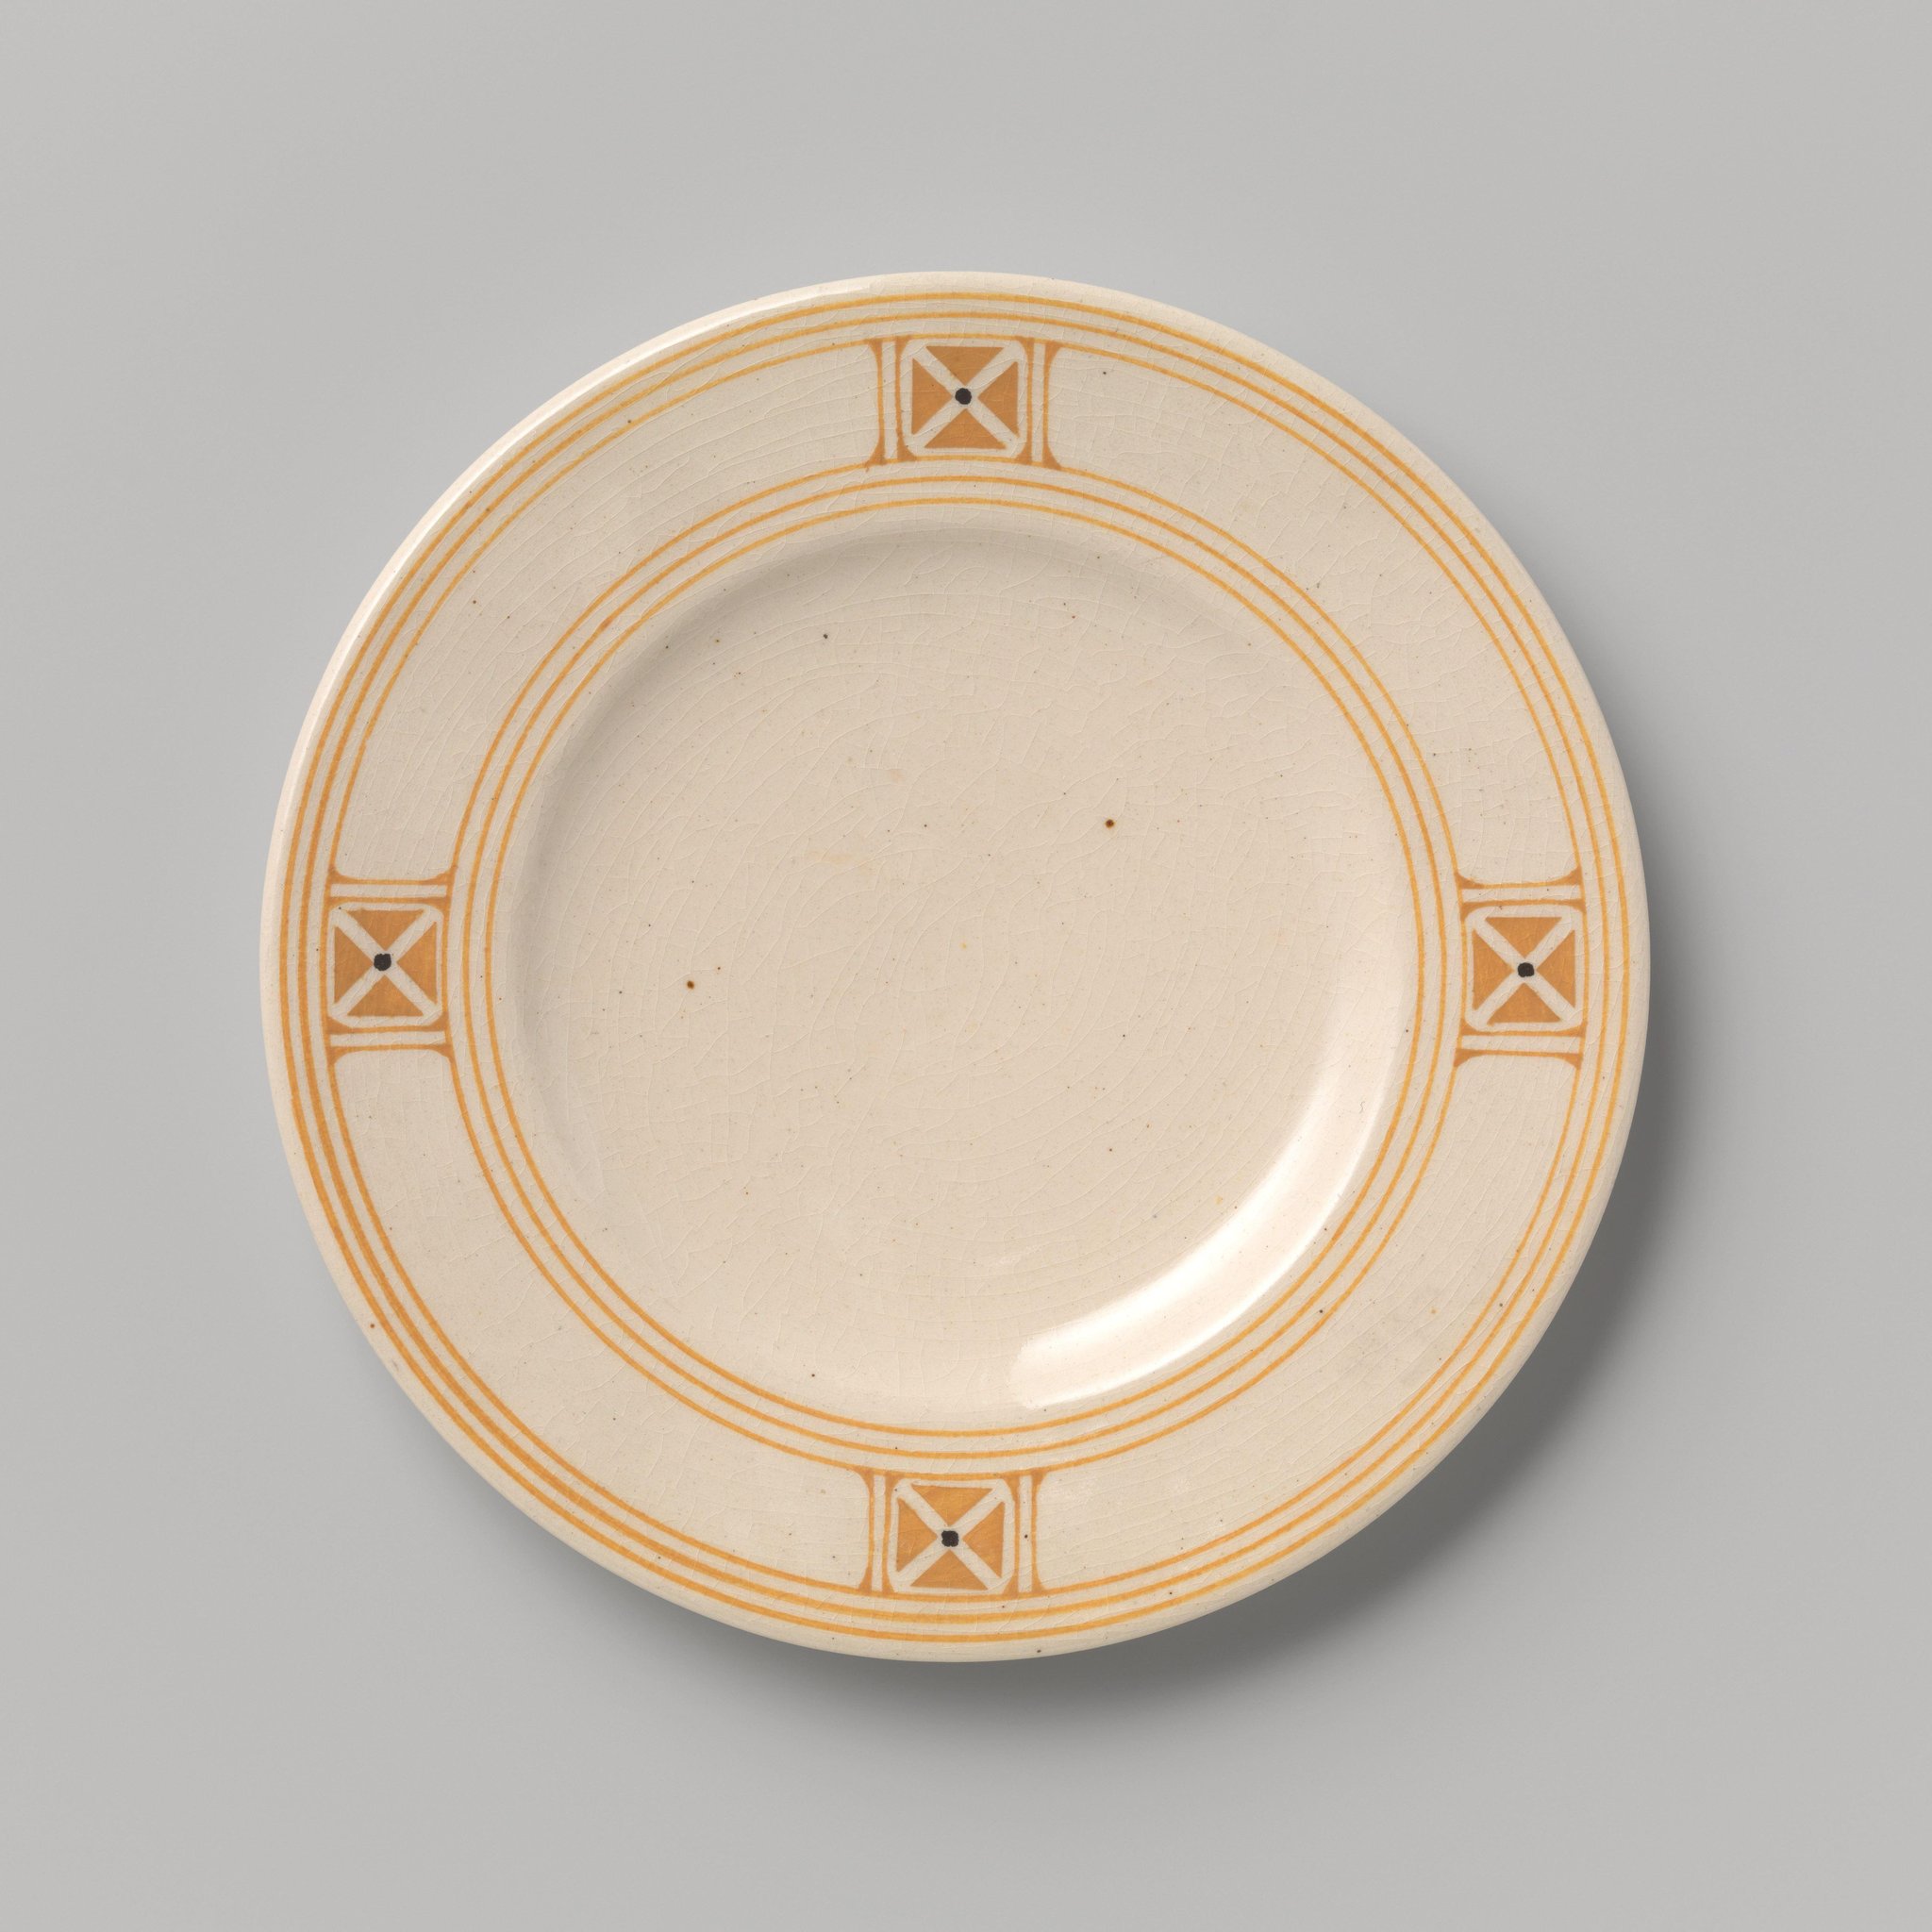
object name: cake plate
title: Gebakschotel versierd met blokmotief en stippen in geel en zwart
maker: chris van der hoef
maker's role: ceramicist, draughtsman, sculptor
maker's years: 1875-1933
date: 1900-1925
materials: earthenware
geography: netherlands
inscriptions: mark: ‘Amphora Holland ontw. C.J. v d Hoef 268A//horizontale streep 1 J.d V.’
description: Gebakschotel van aardewerk. De randen van de schotel zijn versierd met een blokmotief met stippen in geel en zwart tussen aan weerszijden drie gele biezen.